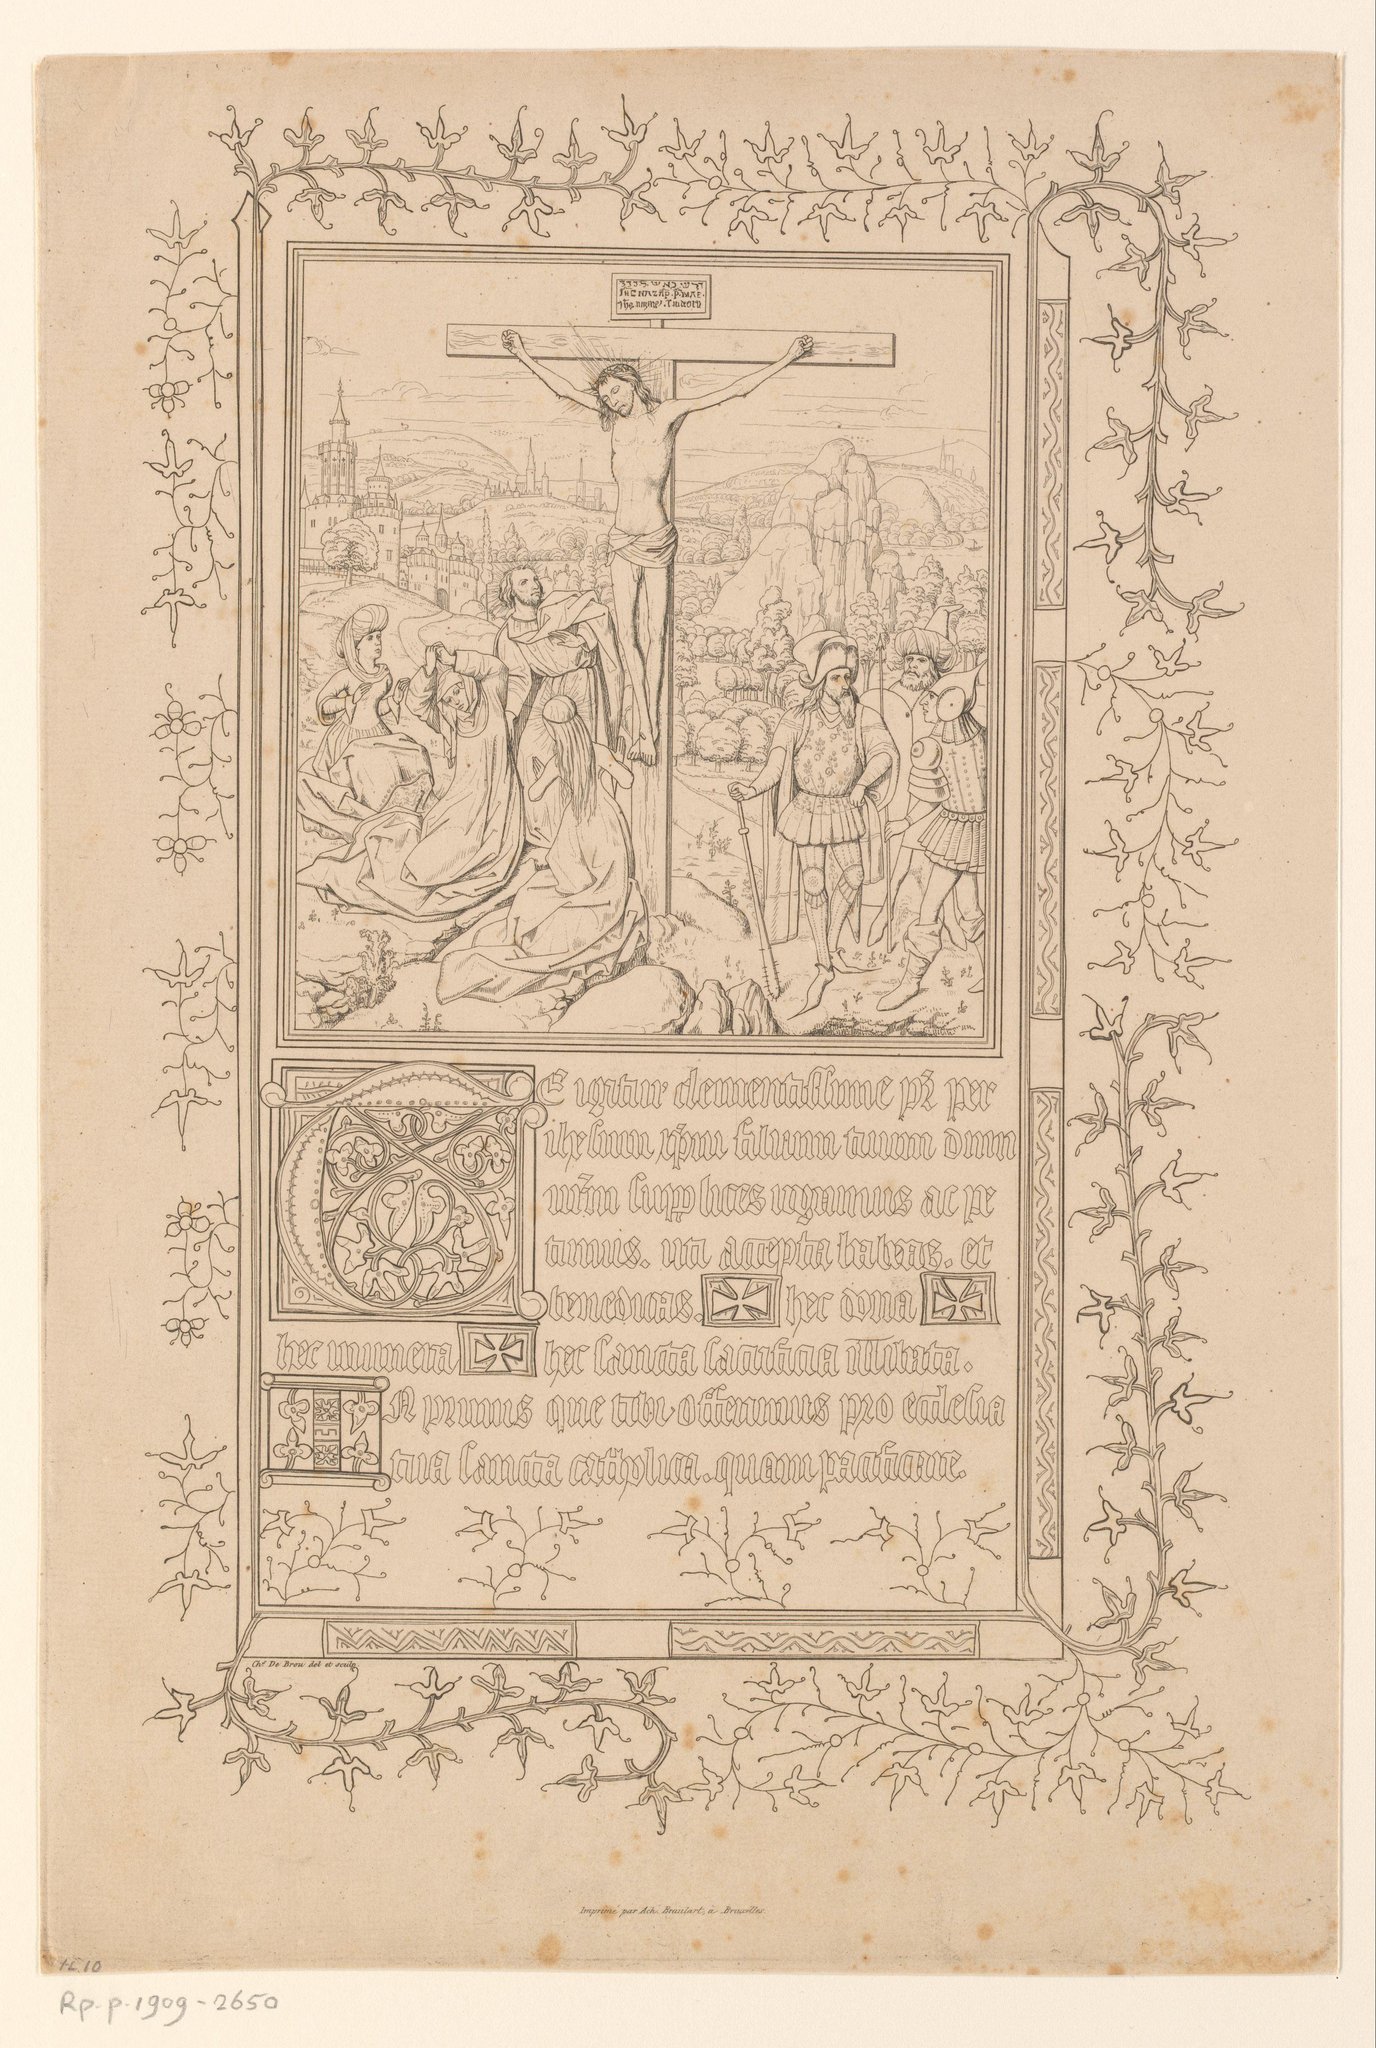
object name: print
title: Christus aan het kruis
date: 1821-1877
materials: paper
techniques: etching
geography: brussels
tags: crucified christ, with particular persons under the cross, crucified christ with mary, john, and mary magdalene, christ is nailed to the erected cross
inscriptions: collector's mark: Lugt 1485, collector's mark: Lugt 2228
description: Christus aan het kruis met onder andere Maria, Jozef en Maria Magdalena. Onder de afbeelding tekst in het Latijn. Rondom een ornamenteel kader met bladmotief.